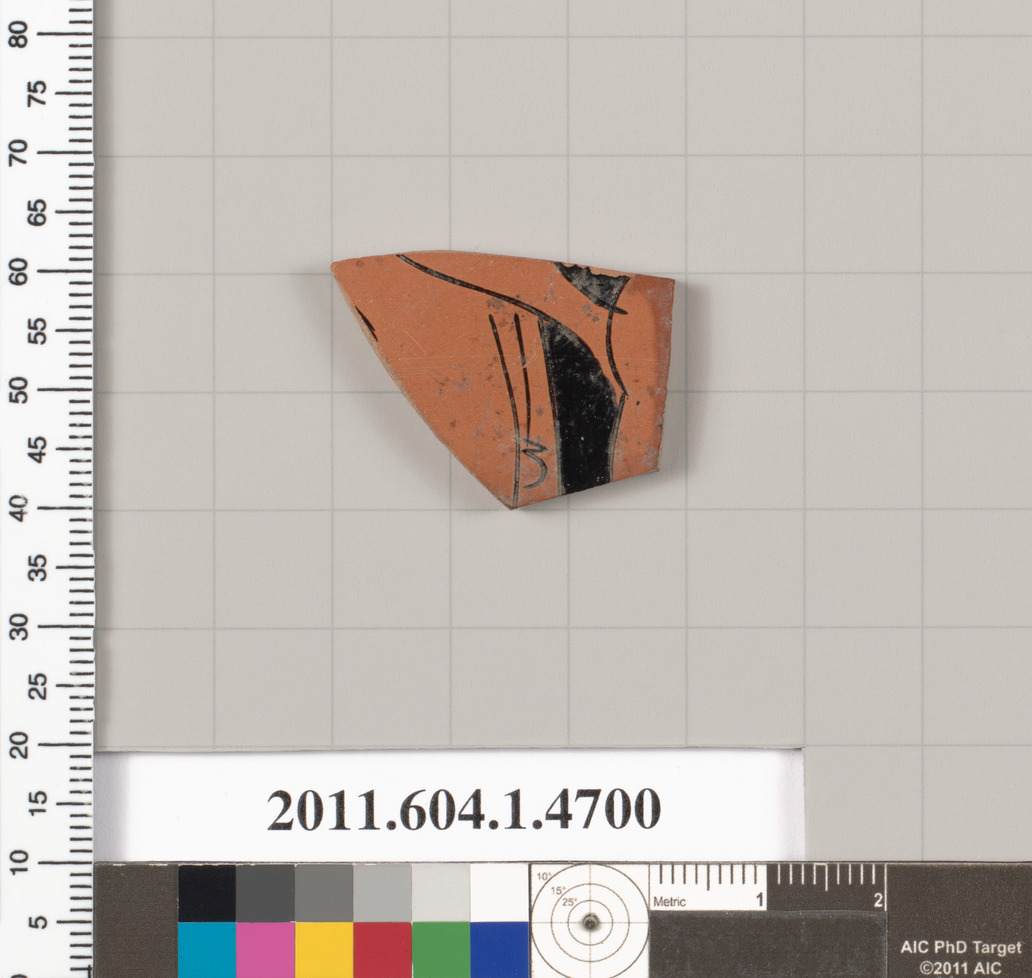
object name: kylix fragment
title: Terracotta fragment of a kylix (drinking cup)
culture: greek, attic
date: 500-480 BCE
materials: terracotta